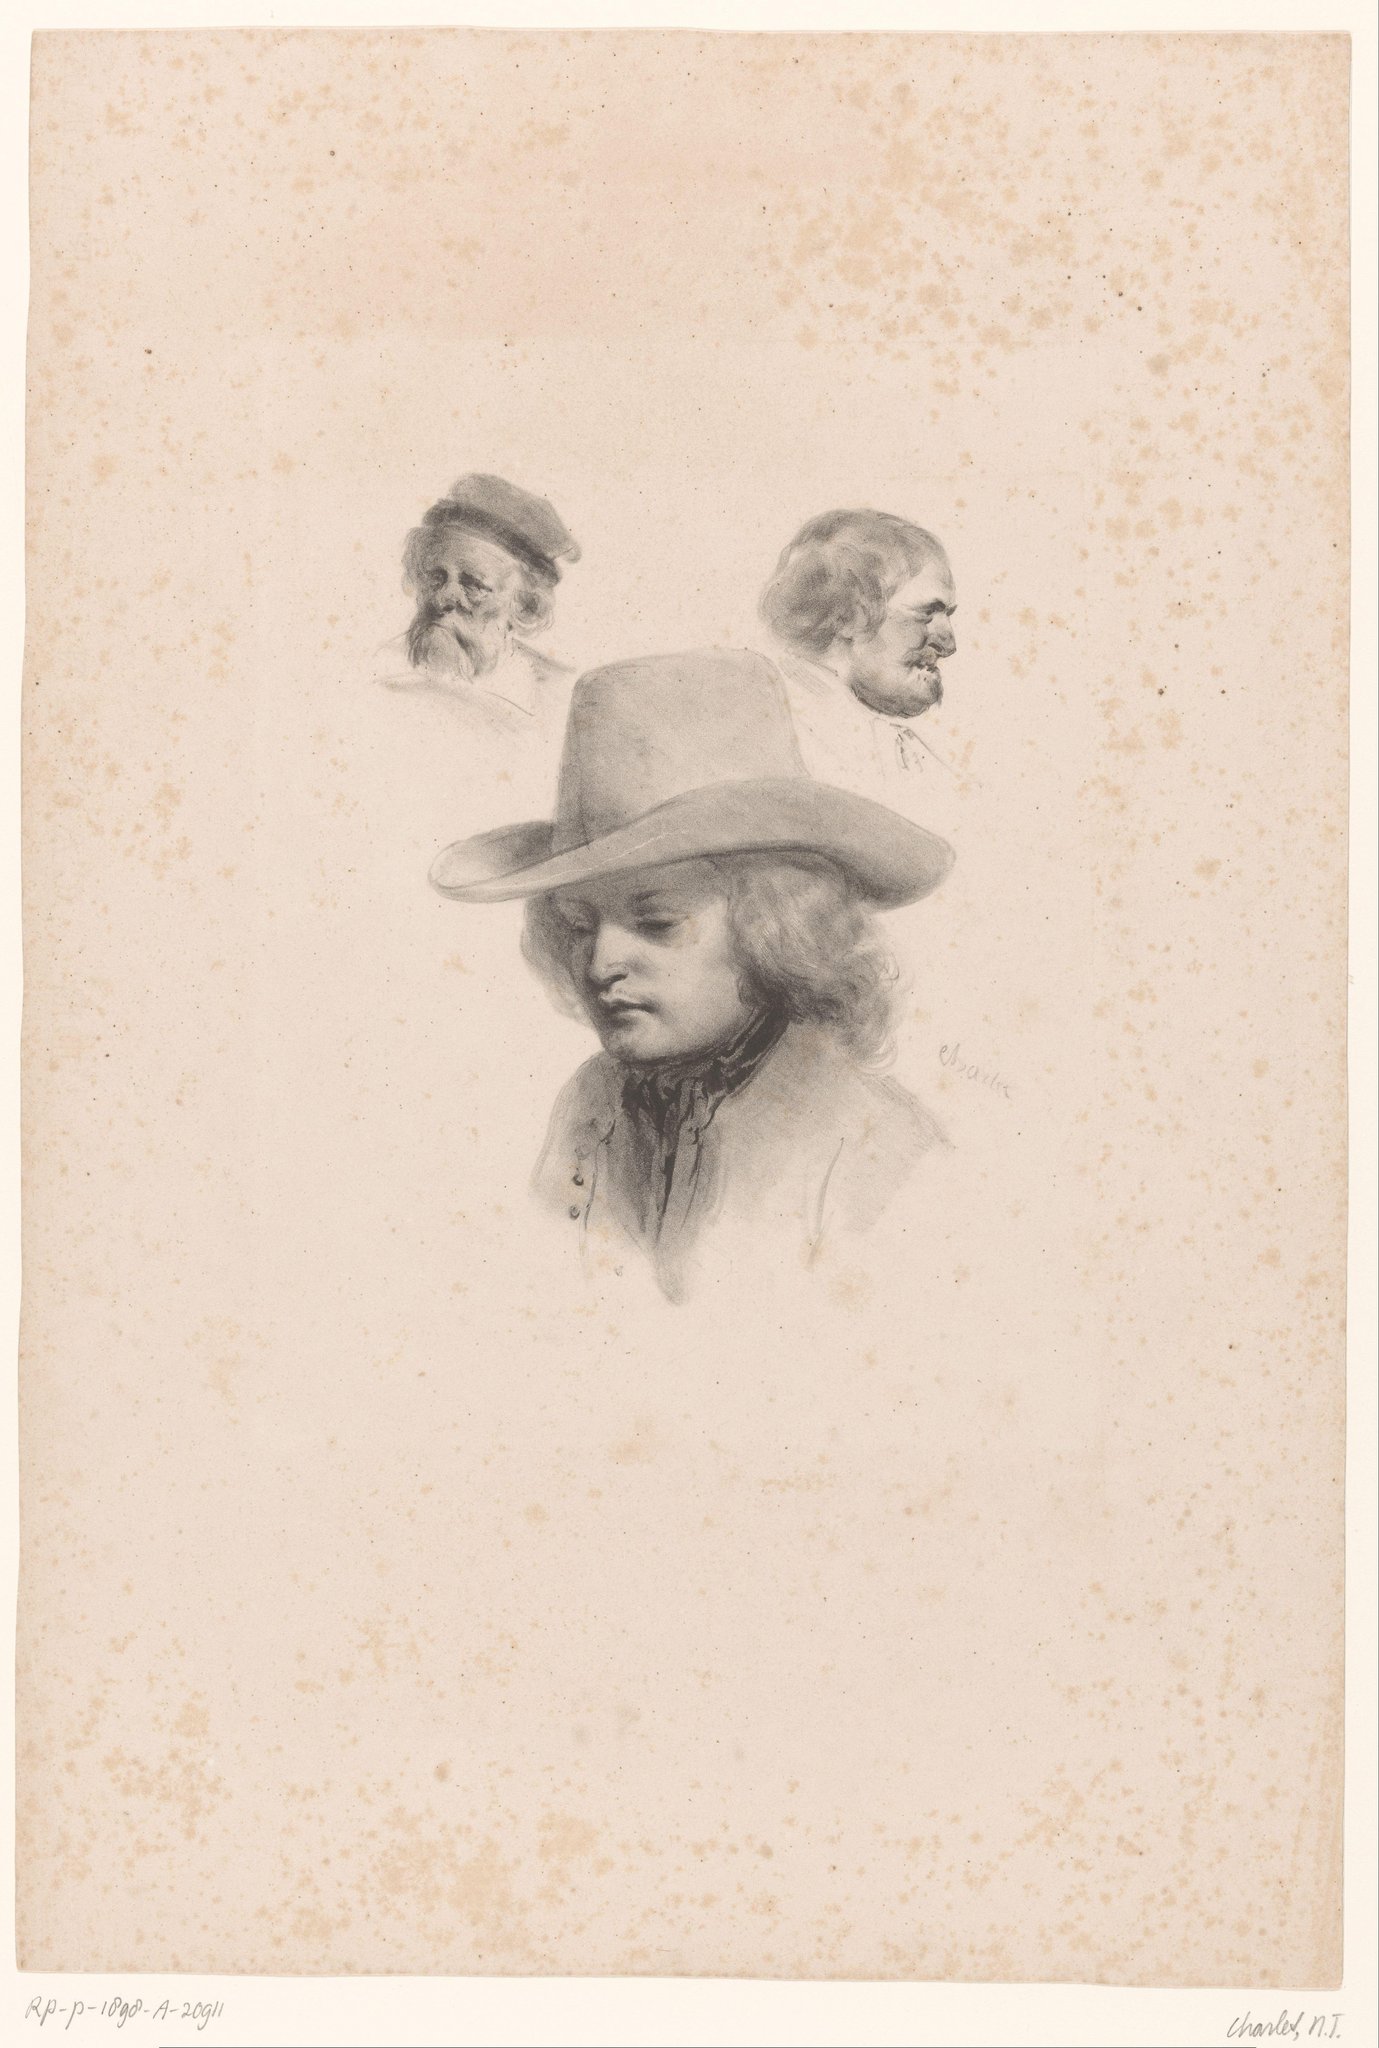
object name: print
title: Studie van drie hoofden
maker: nicolas toussaint charlet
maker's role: draughtsman, painter, print maker, printer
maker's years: 1792-1845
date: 1817-1845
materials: paper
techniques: lithograph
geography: paris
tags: head (human), head-gear: cap (+ men's clothes), youth, adolescent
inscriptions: collector's mark: Lugt 2228a